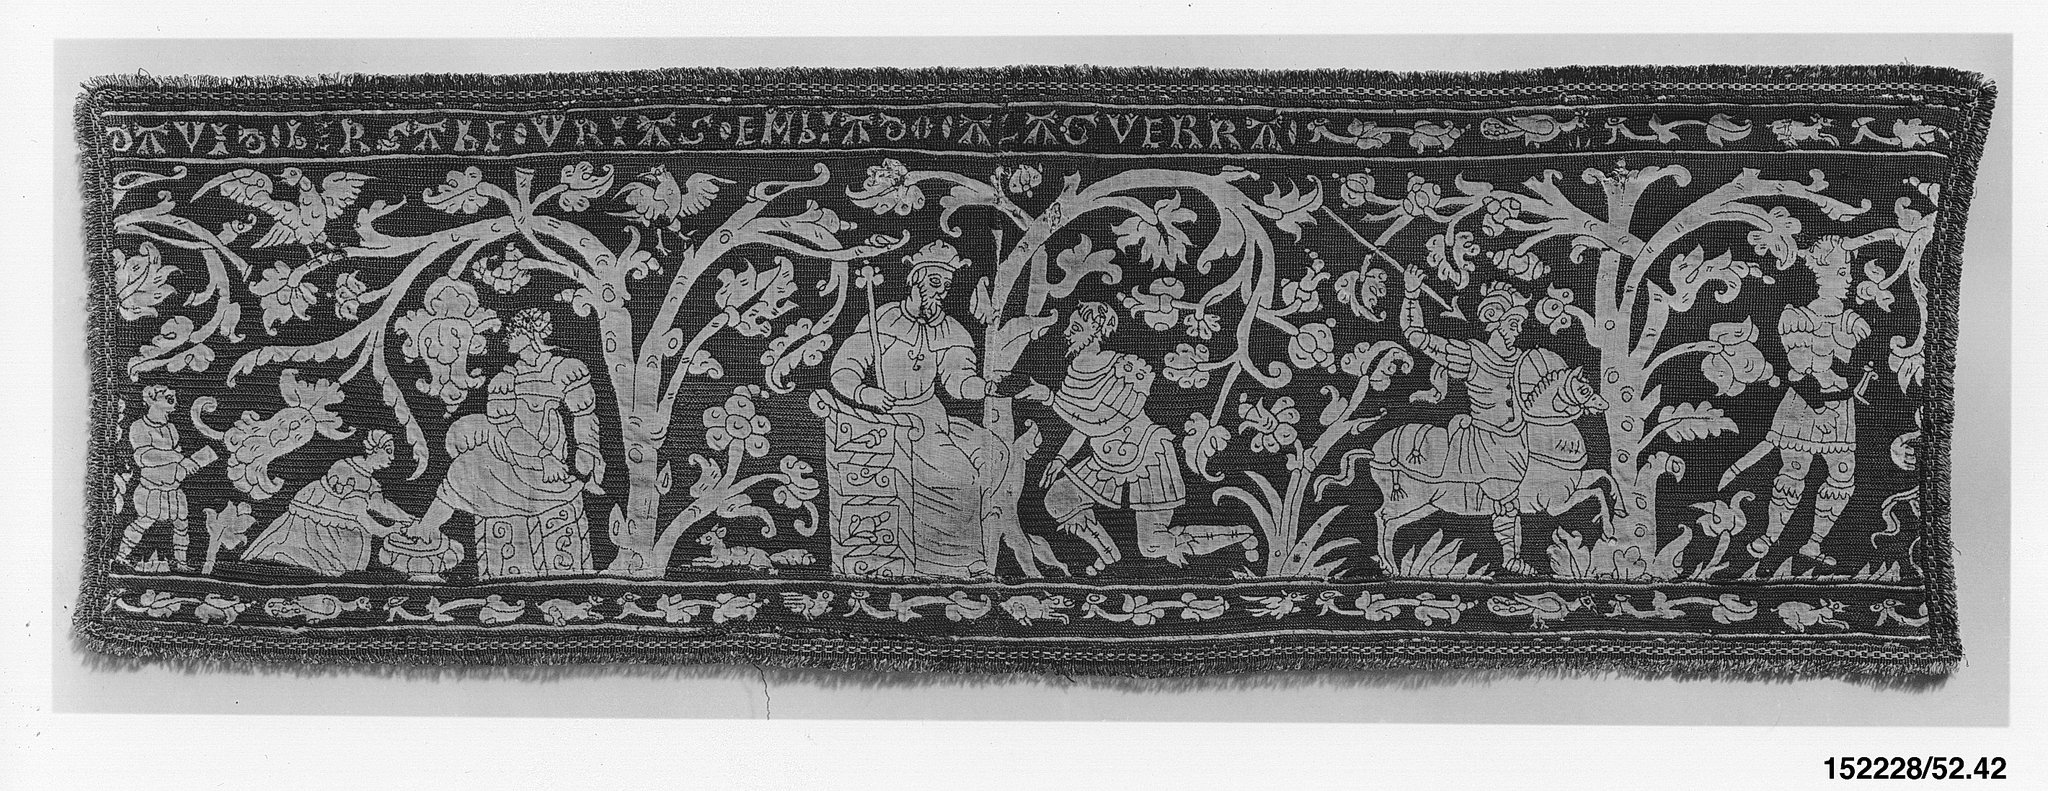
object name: panel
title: Scenes from the Story of David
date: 1501-1600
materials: linen, silk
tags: men,women,horses,trees,david